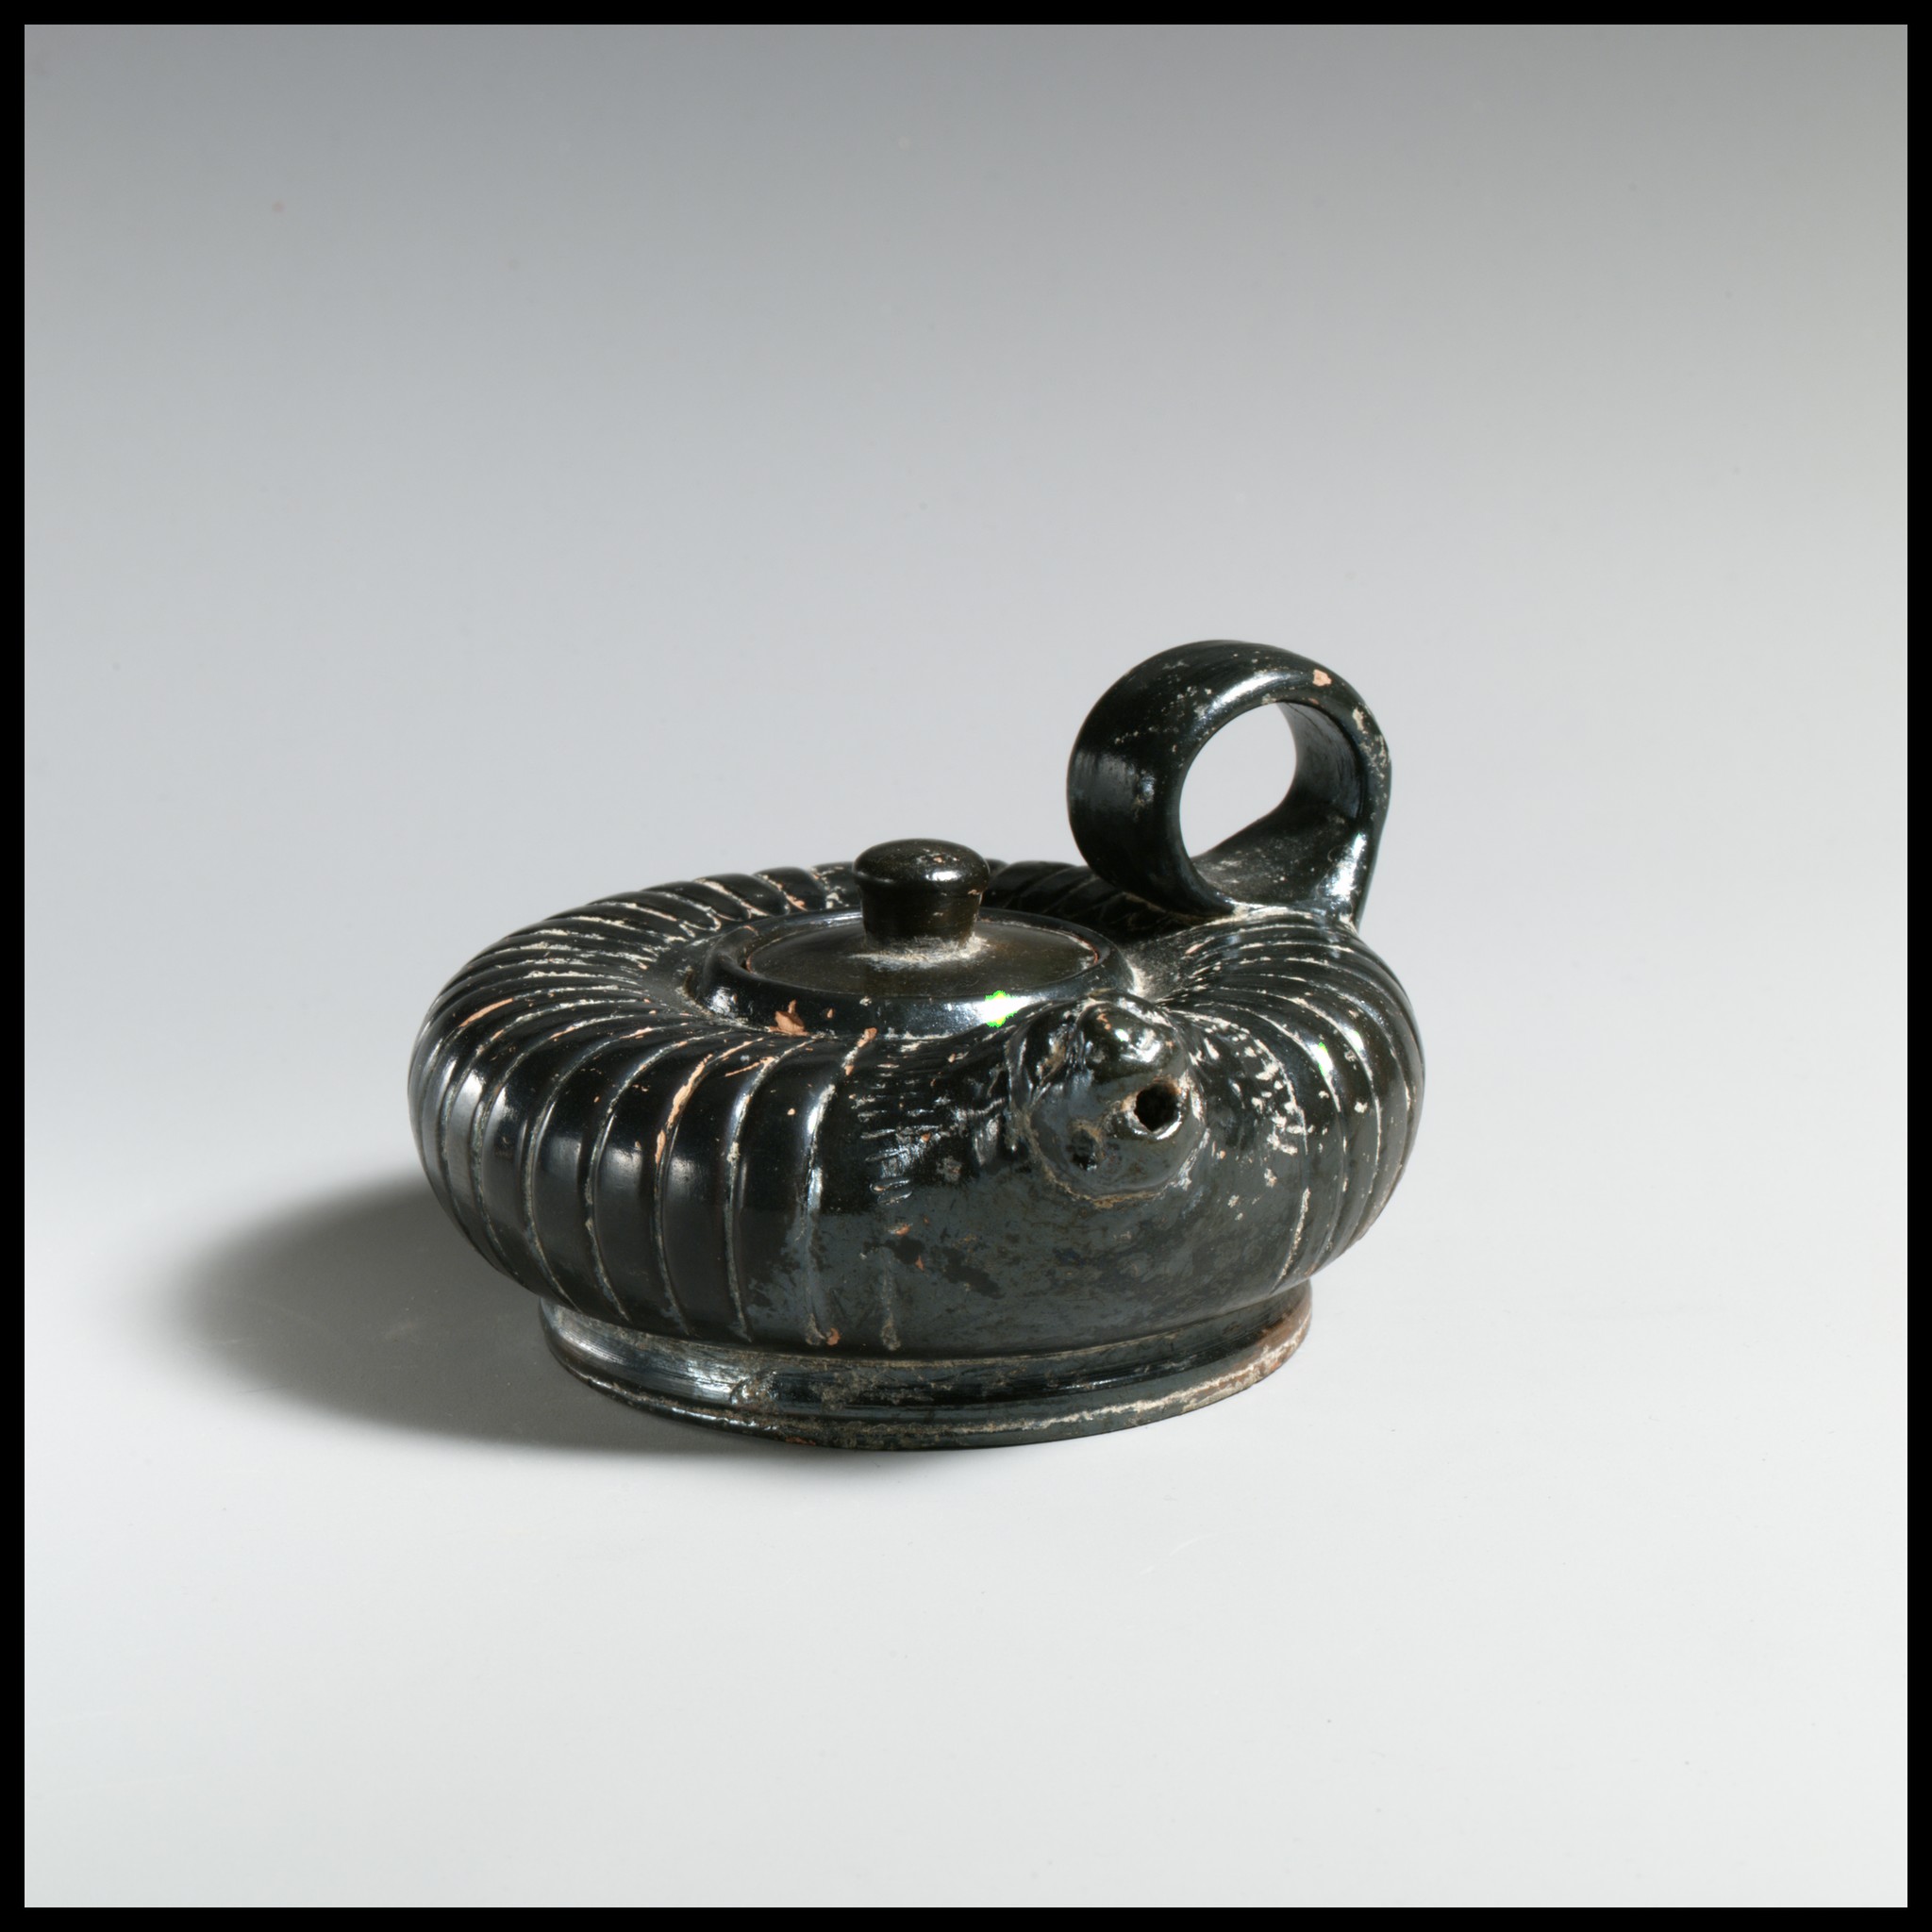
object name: guttus with lid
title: Terracotta guttus (flask with handle and vertical spout)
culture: greek, south italian, apulian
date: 400-301 BCE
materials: terracotta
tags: lions